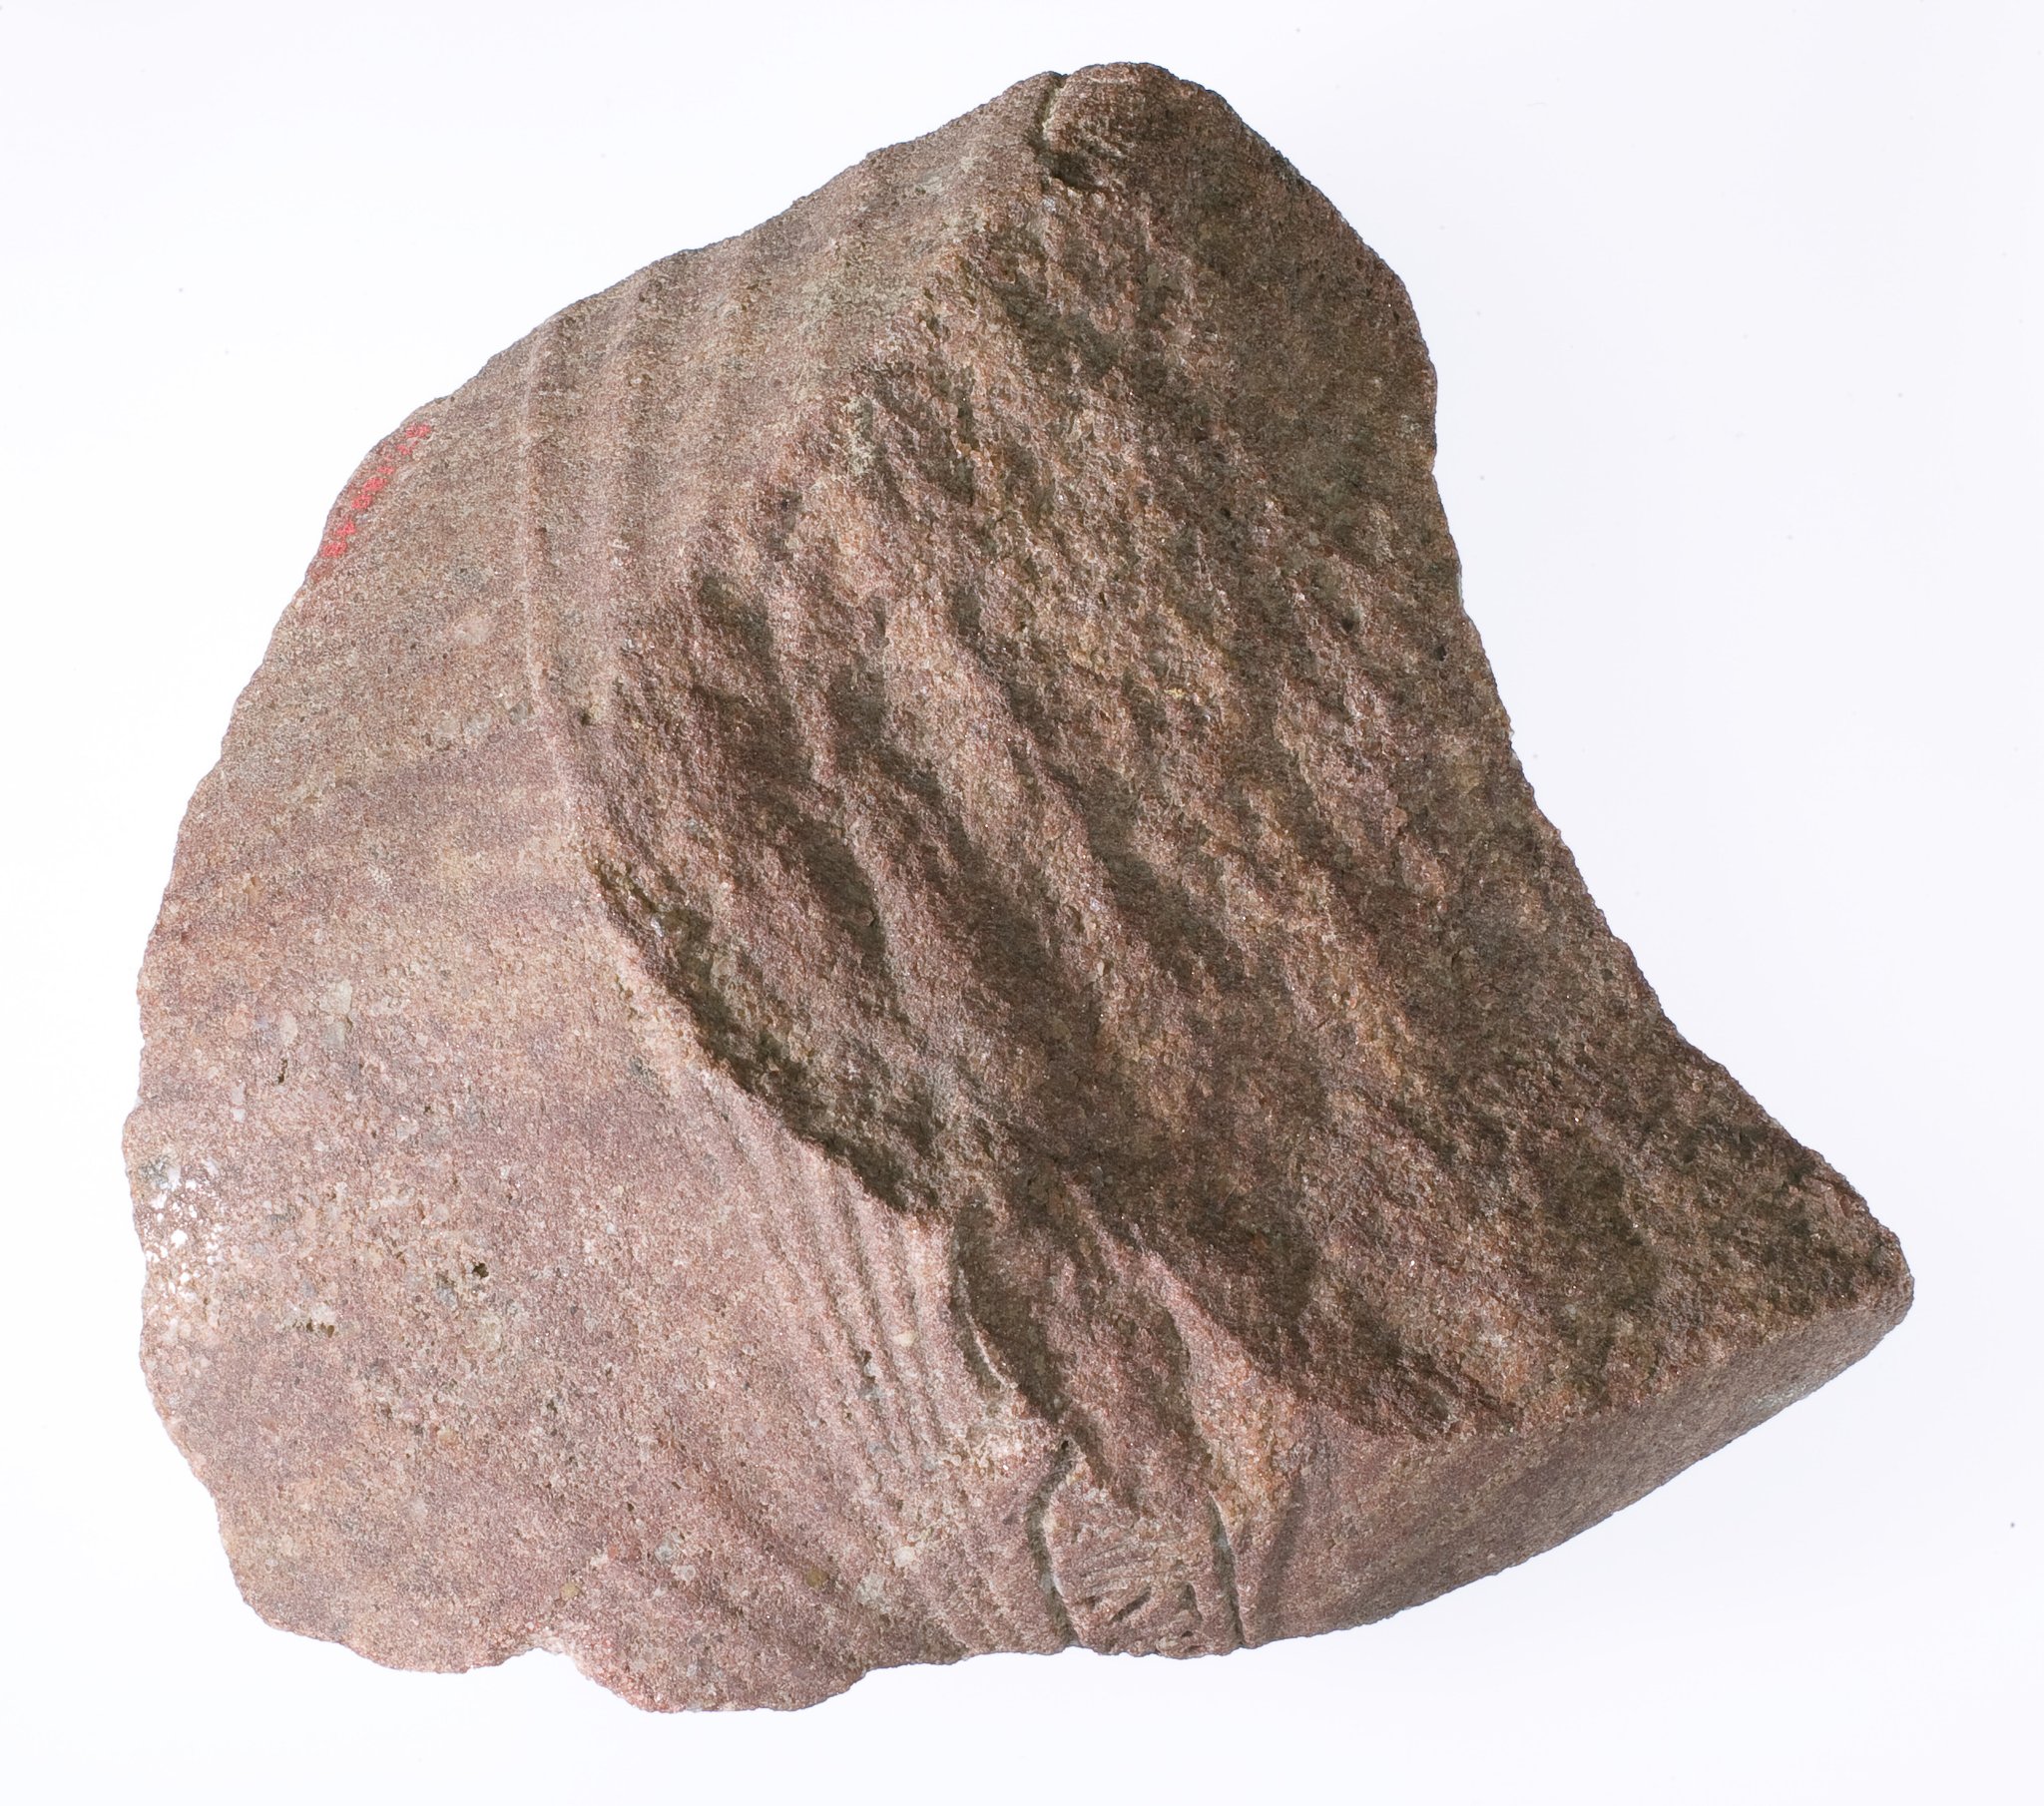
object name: waist of king, bending forward, aten cartouch on belt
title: Fragment of the waist area of the king bending forward, Aten cartouches on the belt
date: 1353-1336 BCE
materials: quartzite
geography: egypt